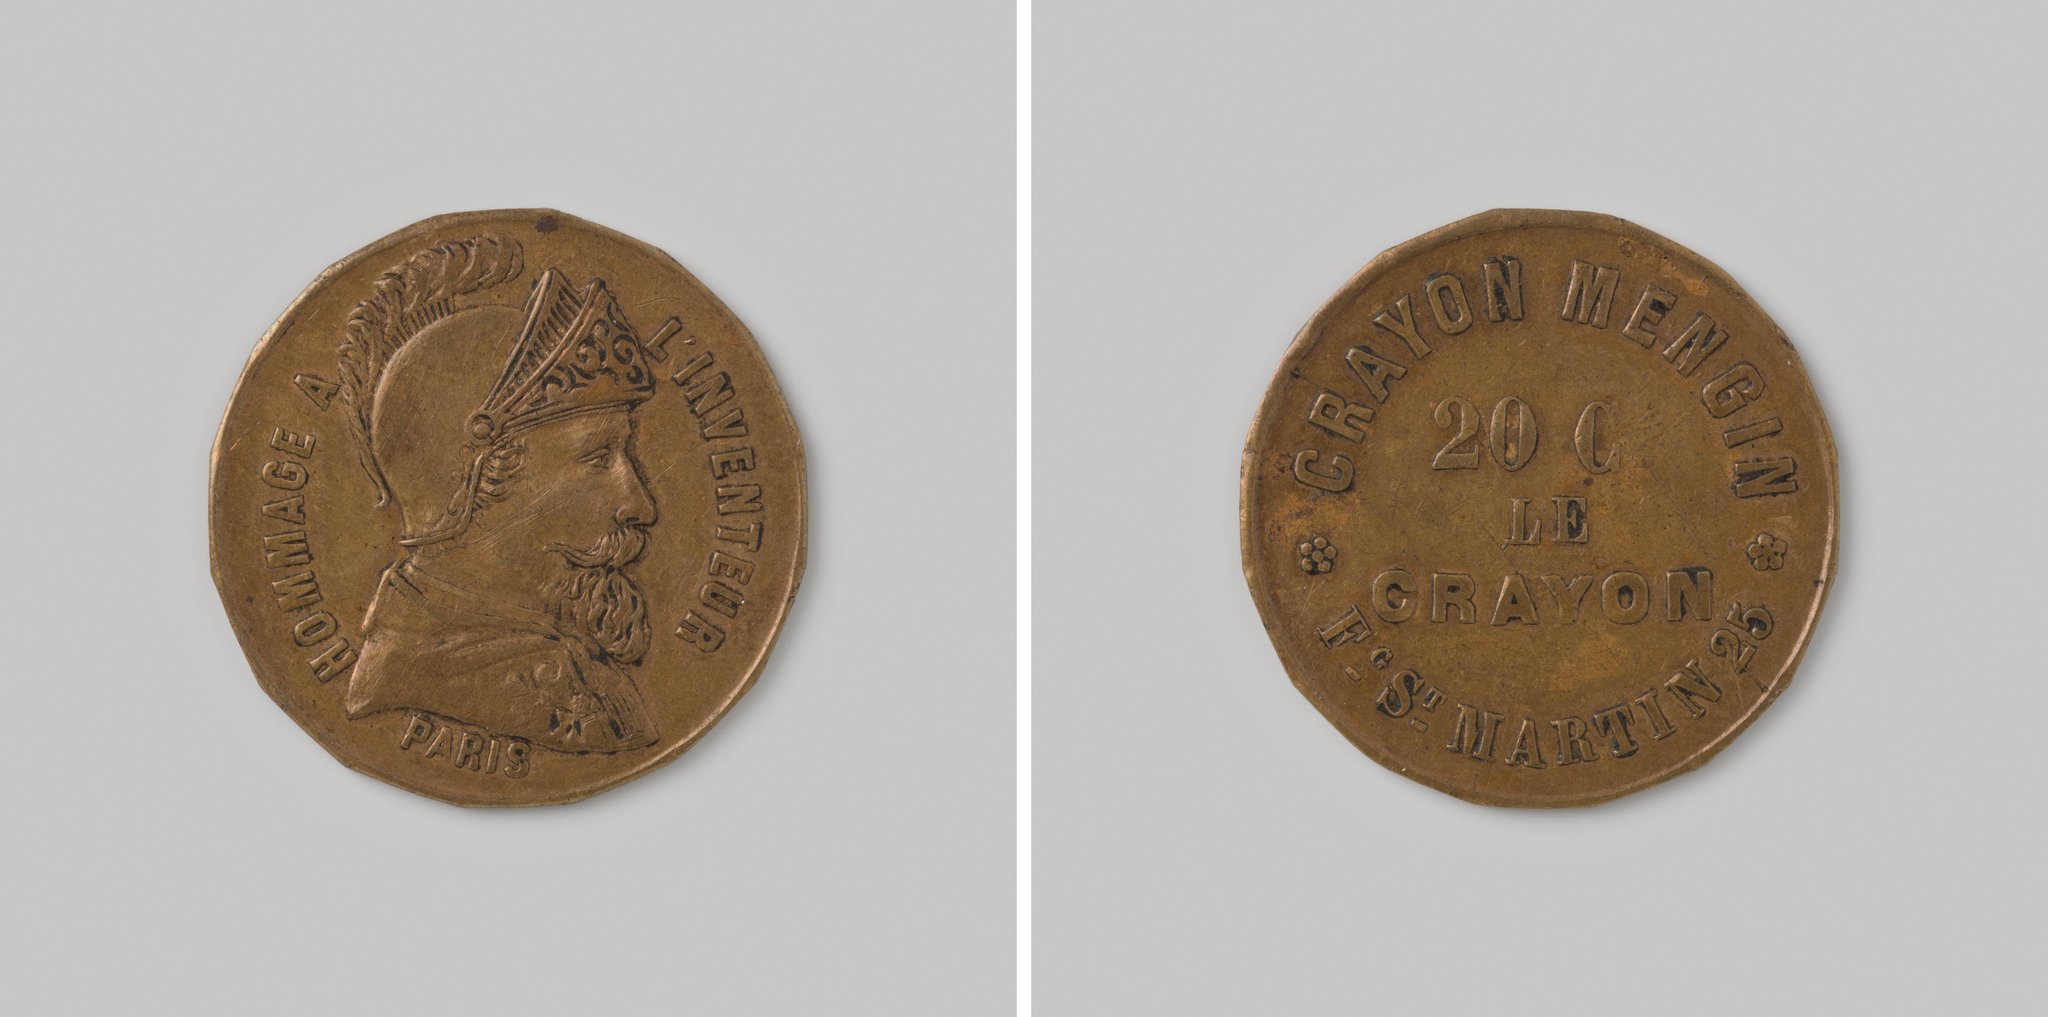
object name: history medal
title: Reclamepenning Crayon Mengin te Parijs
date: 1850-1900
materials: brass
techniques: striking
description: Velhoekige messing penning, op de voorzijde een gehelmd borstbeeld naar rechts met omschrift, op de keerzijde drie regels tekst met omschrift.